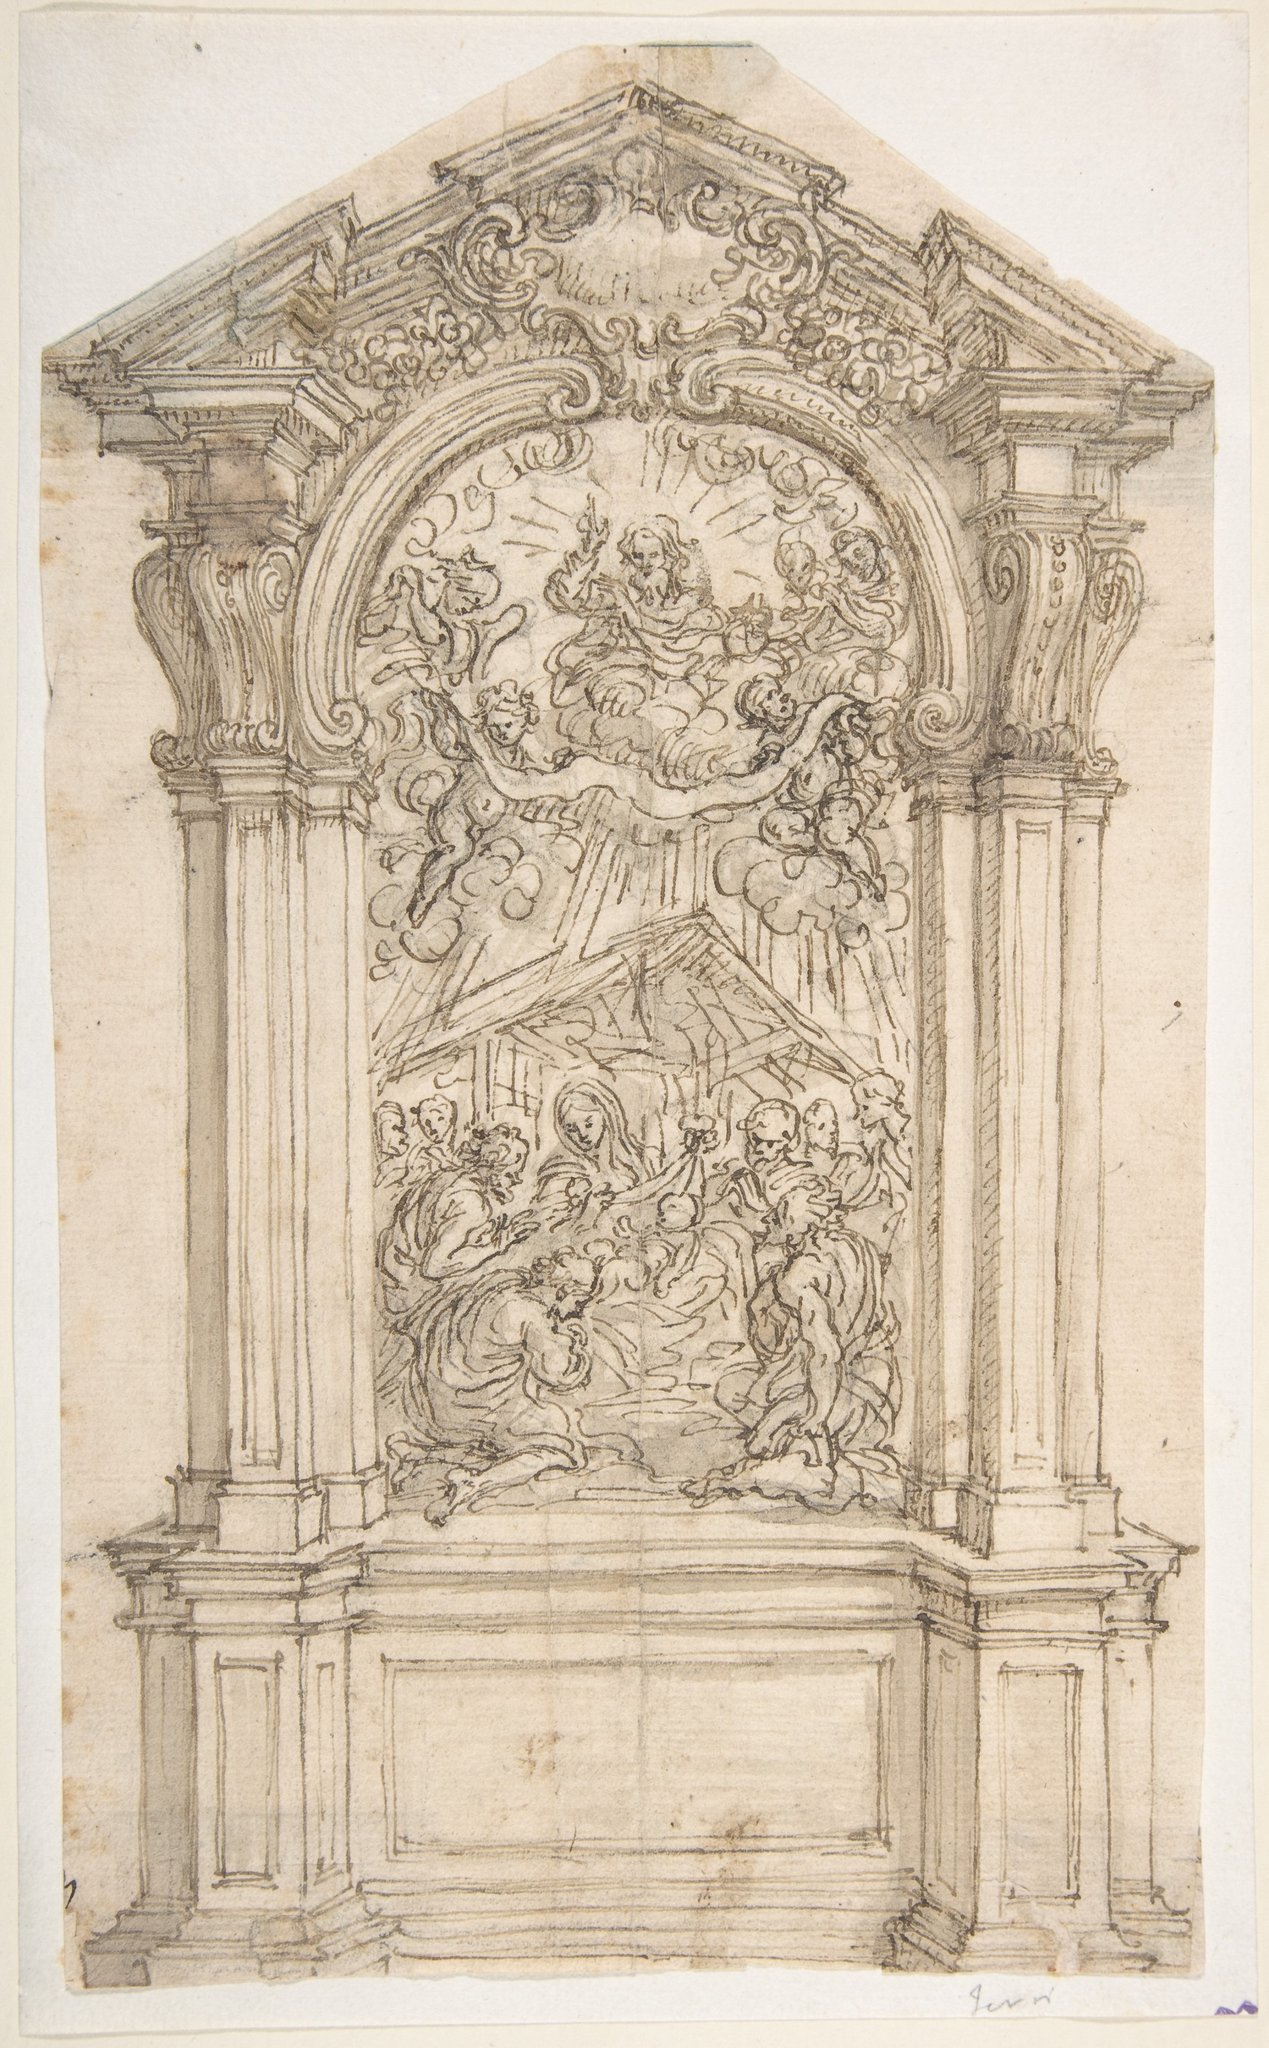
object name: drawing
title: Design for an Altar with a Painting of the Adoration of the Shepherds and God the Father Above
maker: giovanni battista foggini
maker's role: artist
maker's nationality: italian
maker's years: 1652-1725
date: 1672-1725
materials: graphite, ink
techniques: brush, pen, wash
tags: altars,adoration of the shepherds,god the father